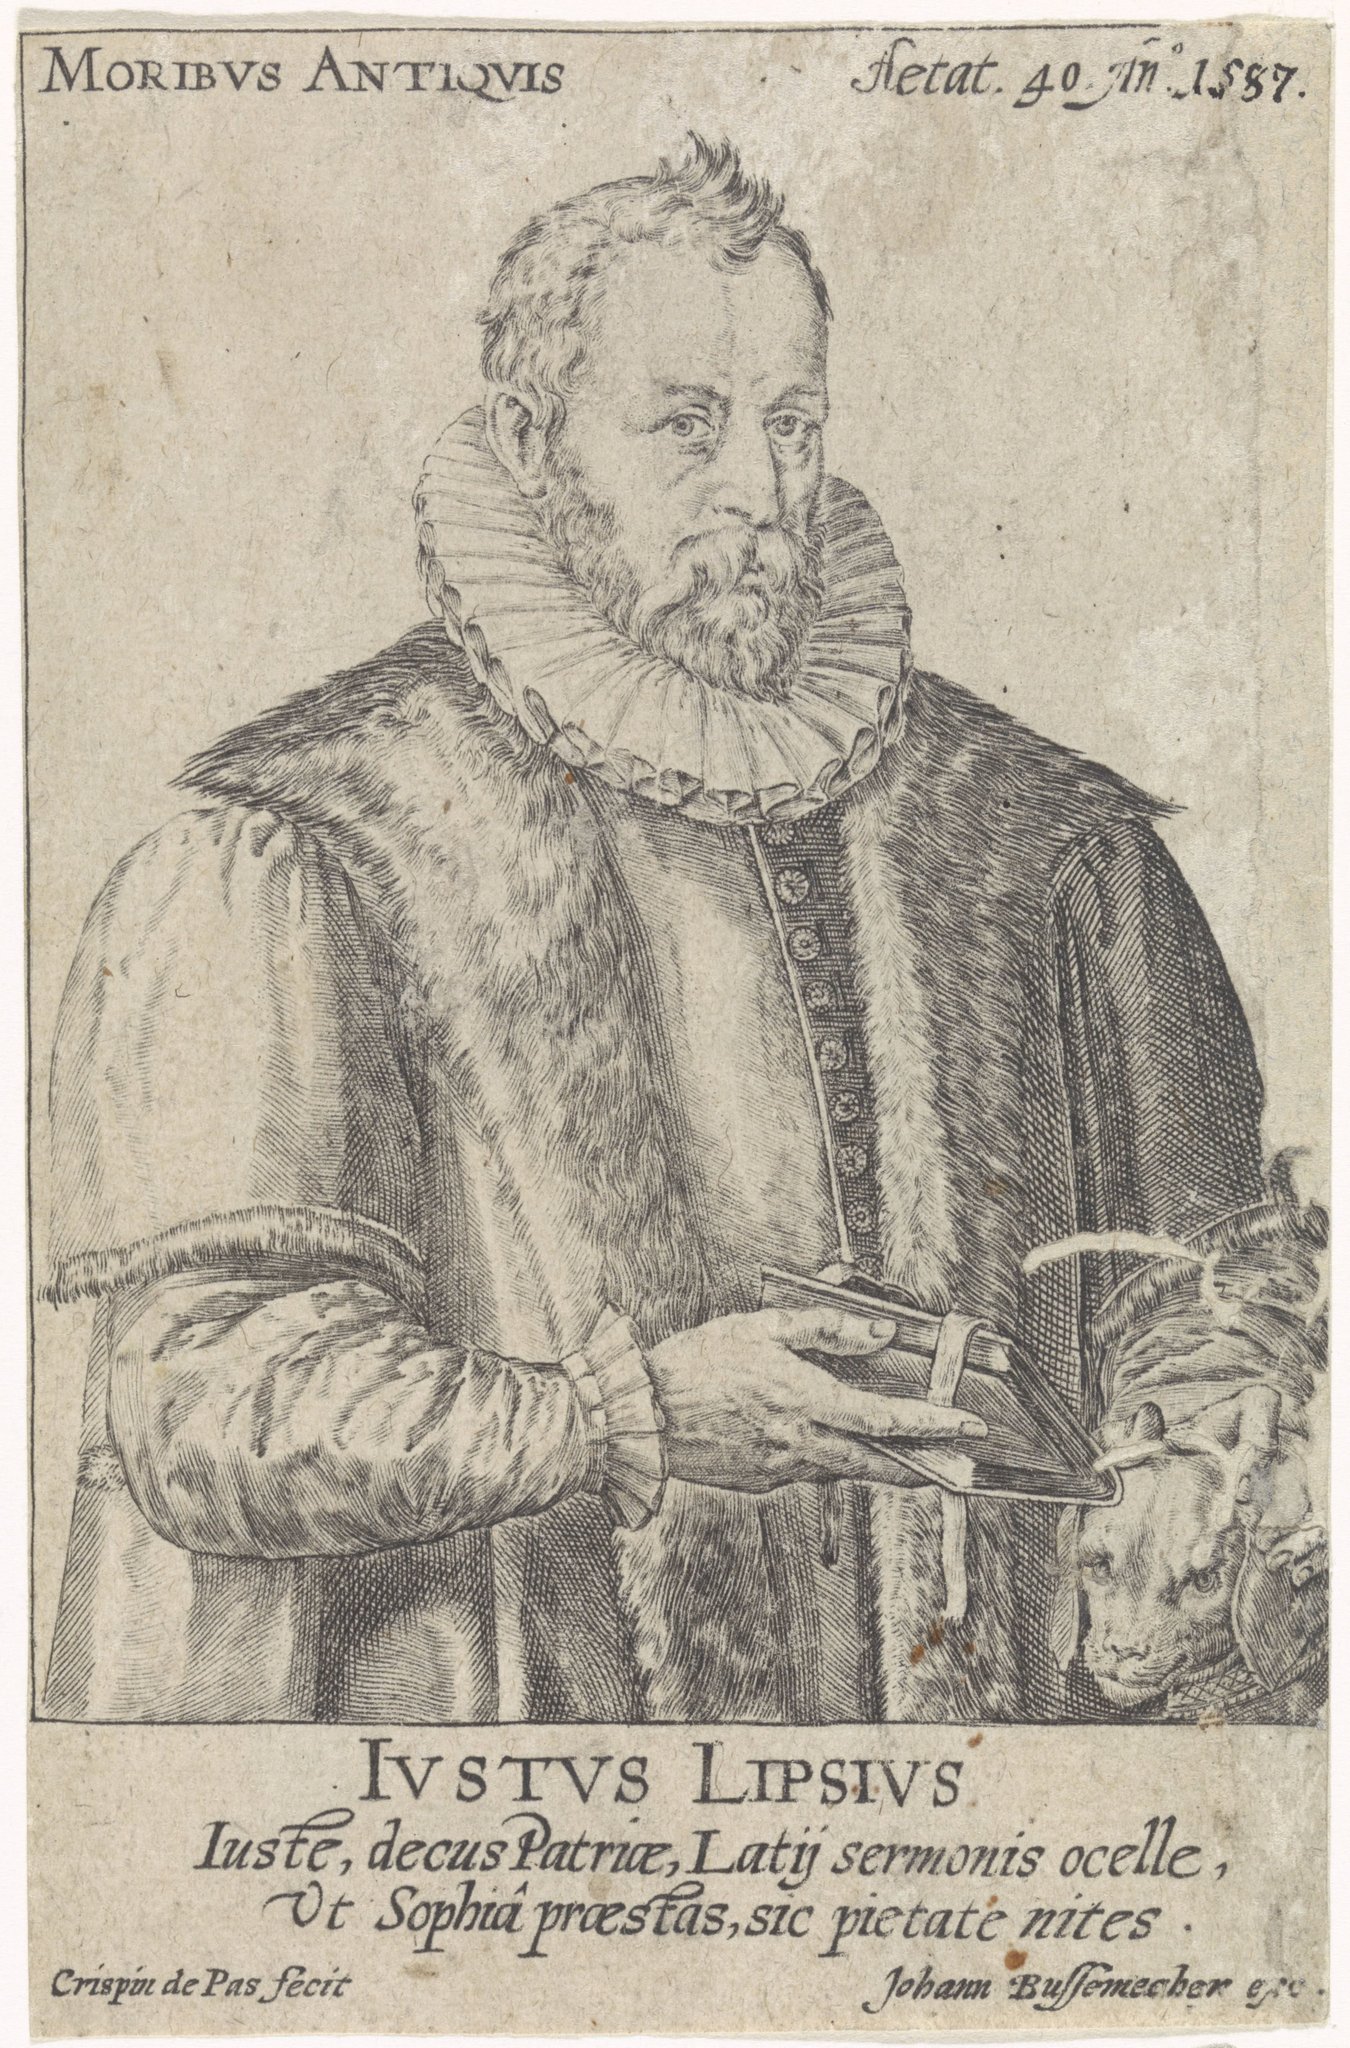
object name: print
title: Portret van Justus Lipsius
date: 1587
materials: paper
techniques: engraving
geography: aachen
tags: louvain, justus lipsius, historical persons, friendship between man and animal; caressing, petting, dog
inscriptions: collector's mark: Lugt 2228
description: Portret van de humanist en geleerde Justus Lipsius, op 40-jarige leeftijd. Hij aait de kop van zijn hond. In de marge de naam van de geportretteerde en een tweeregelig lofdicht in het Latijn. Kopie in spiegelbeeld naar de gelijknamige prent van Hendrick Goltzius.